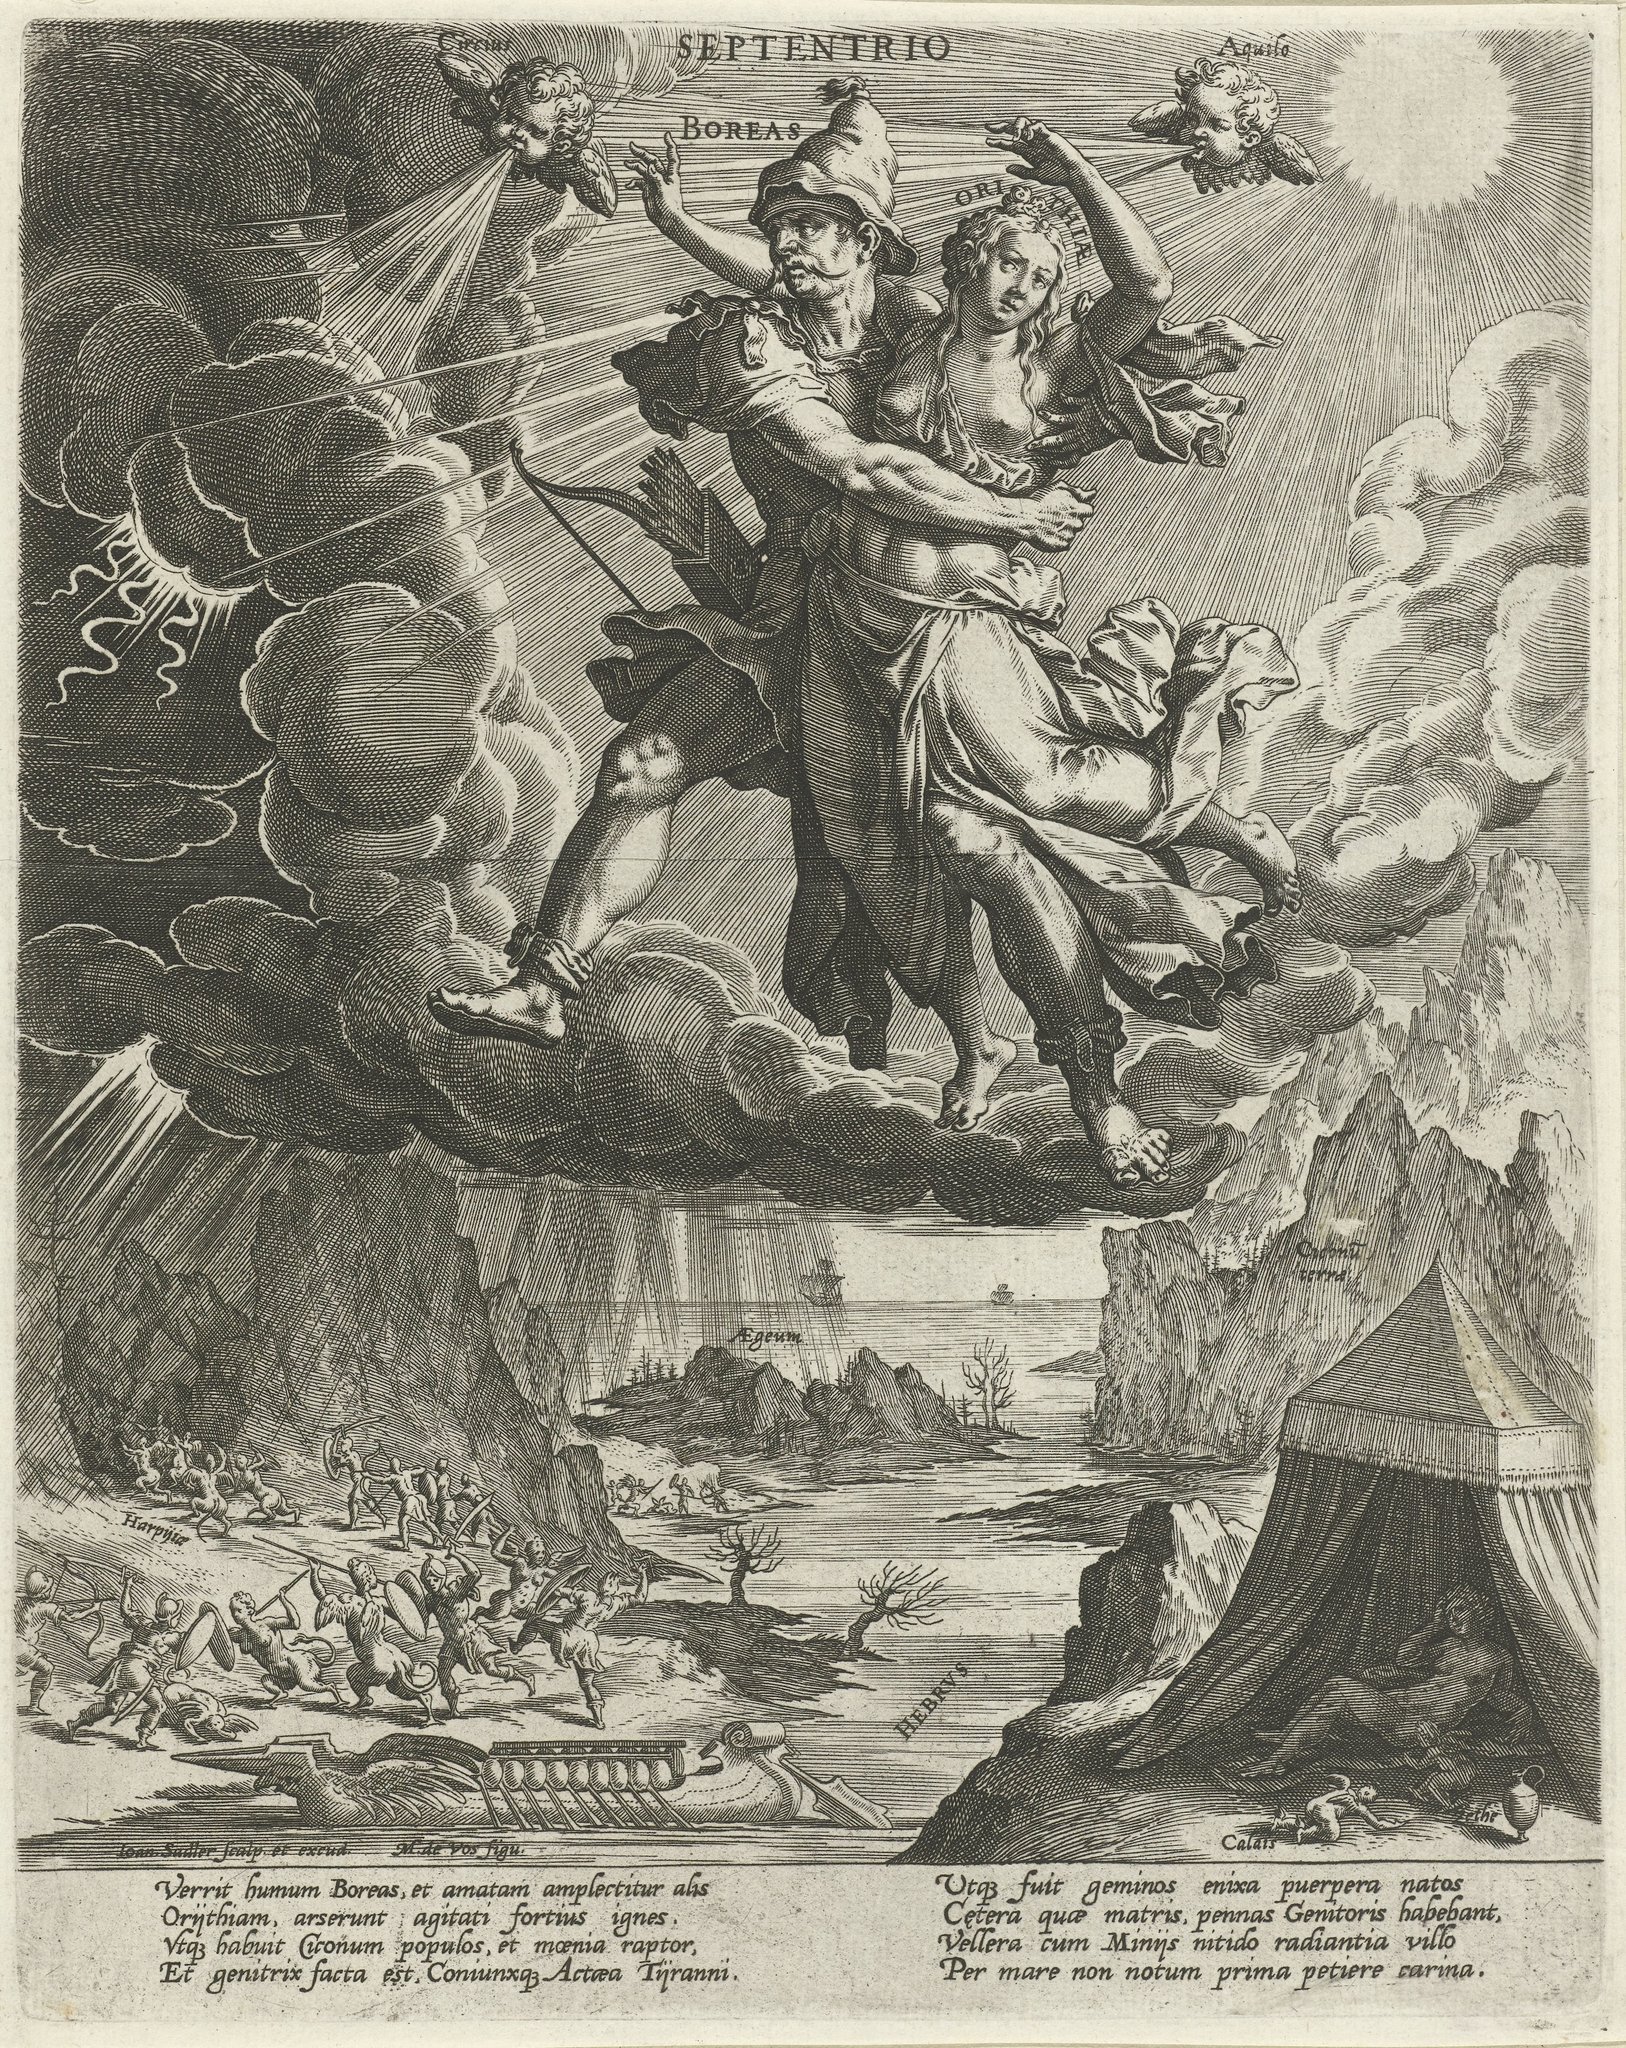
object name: print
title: Septentrio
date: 1560-1600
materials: paper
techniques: engraving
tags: north wind, 'aquilo', 'boreas', 'septentrionarius' (one of eight directions), calais and zetes, the boreadae, boreas abducting orithyia, north wind (one of the four main directions), calais and zetes chase away the harpies that plagued phineus, harpies (classical mythology)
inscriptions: collector's mark: Lugt 240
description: In de lucht Boreas, de god van de noordenwind. Hij ontvoert Orithyia, een Atheense prinses. De winden Circius en Aquilo helpen hem. Boreas zorgt voor een woeste wind met storm en regen. Onderaan links vechten de argonauten tegen de harpijen. Rechts Orithyia en haar twee kinderen, de gevleugelde tweeling Zetes en Calaïs. In de marge een Latijns onderschrift met uitleg over de noordenwind. De prent maakt deel uit van een vierdelige serie met als onderwerp de vier windstreken.